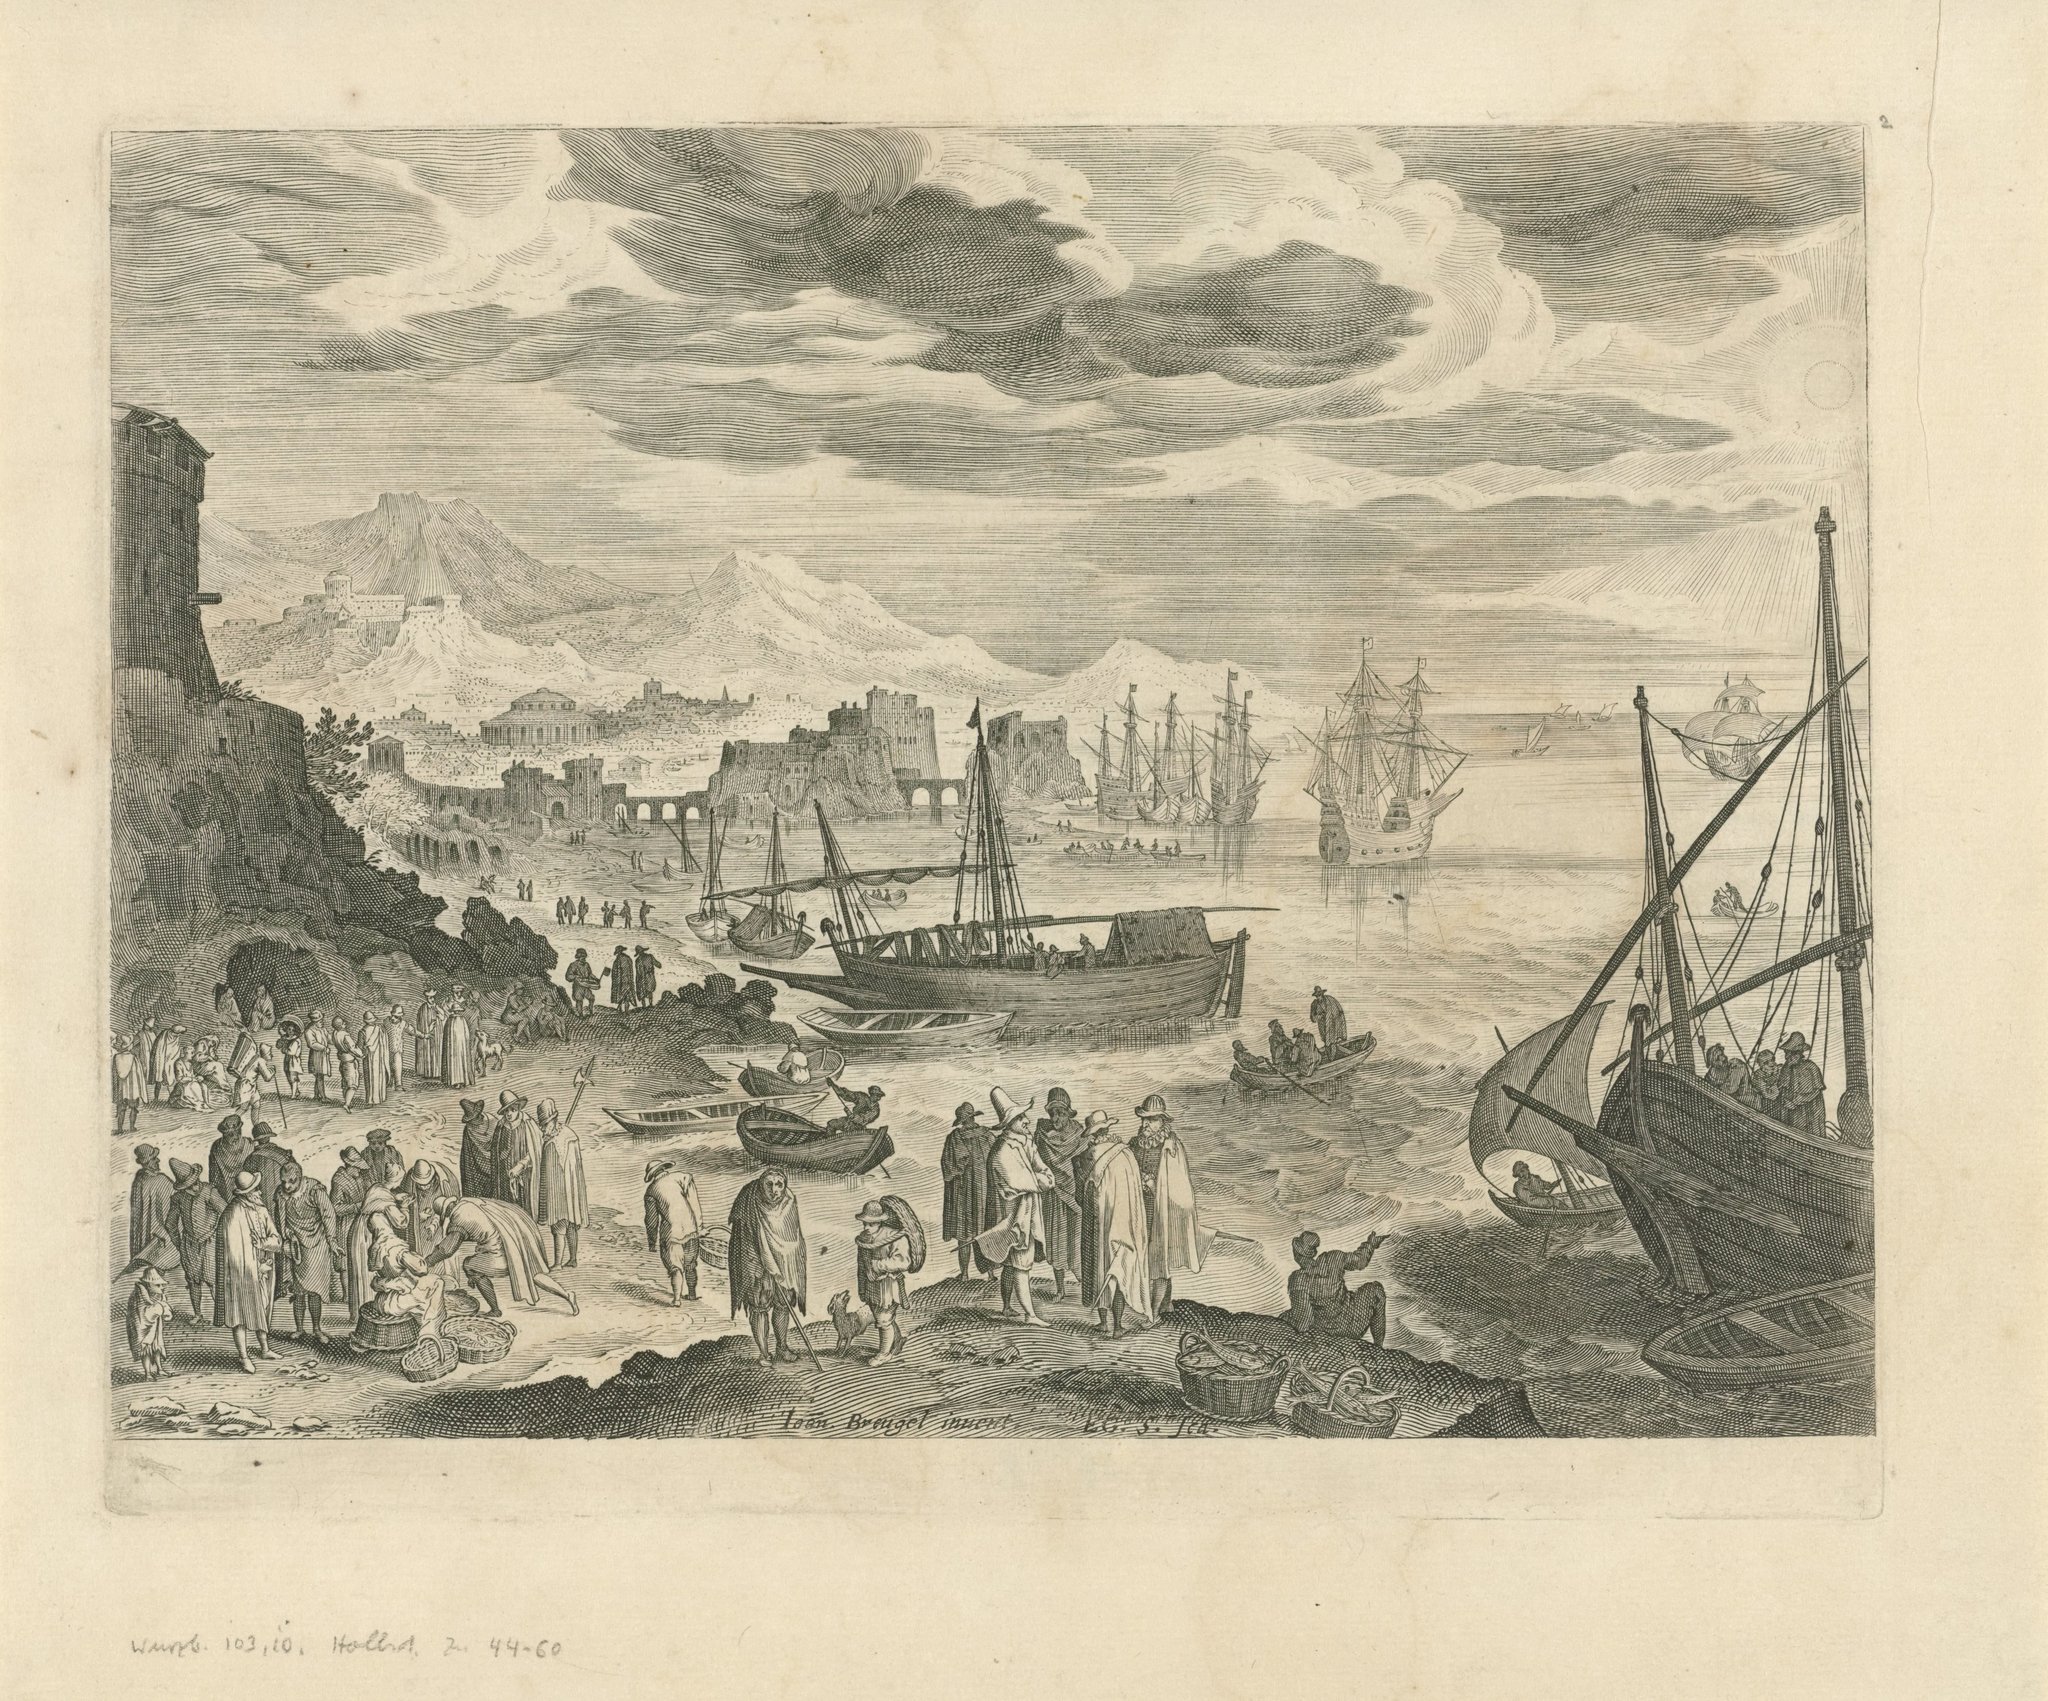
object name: print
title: Zeehaven met vissers en vishandelaren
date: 1580-1629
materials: paper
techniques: engraving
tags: harbour, sailing-ship, sailing-boat, sea and coastal fishery, merchant, salesman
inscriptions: collector's mark: Lugt 2760, collector's mark: Lugt 2228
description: Haven met vissersboten. Op de voorgrond vissers, handelaren en bedelaars.